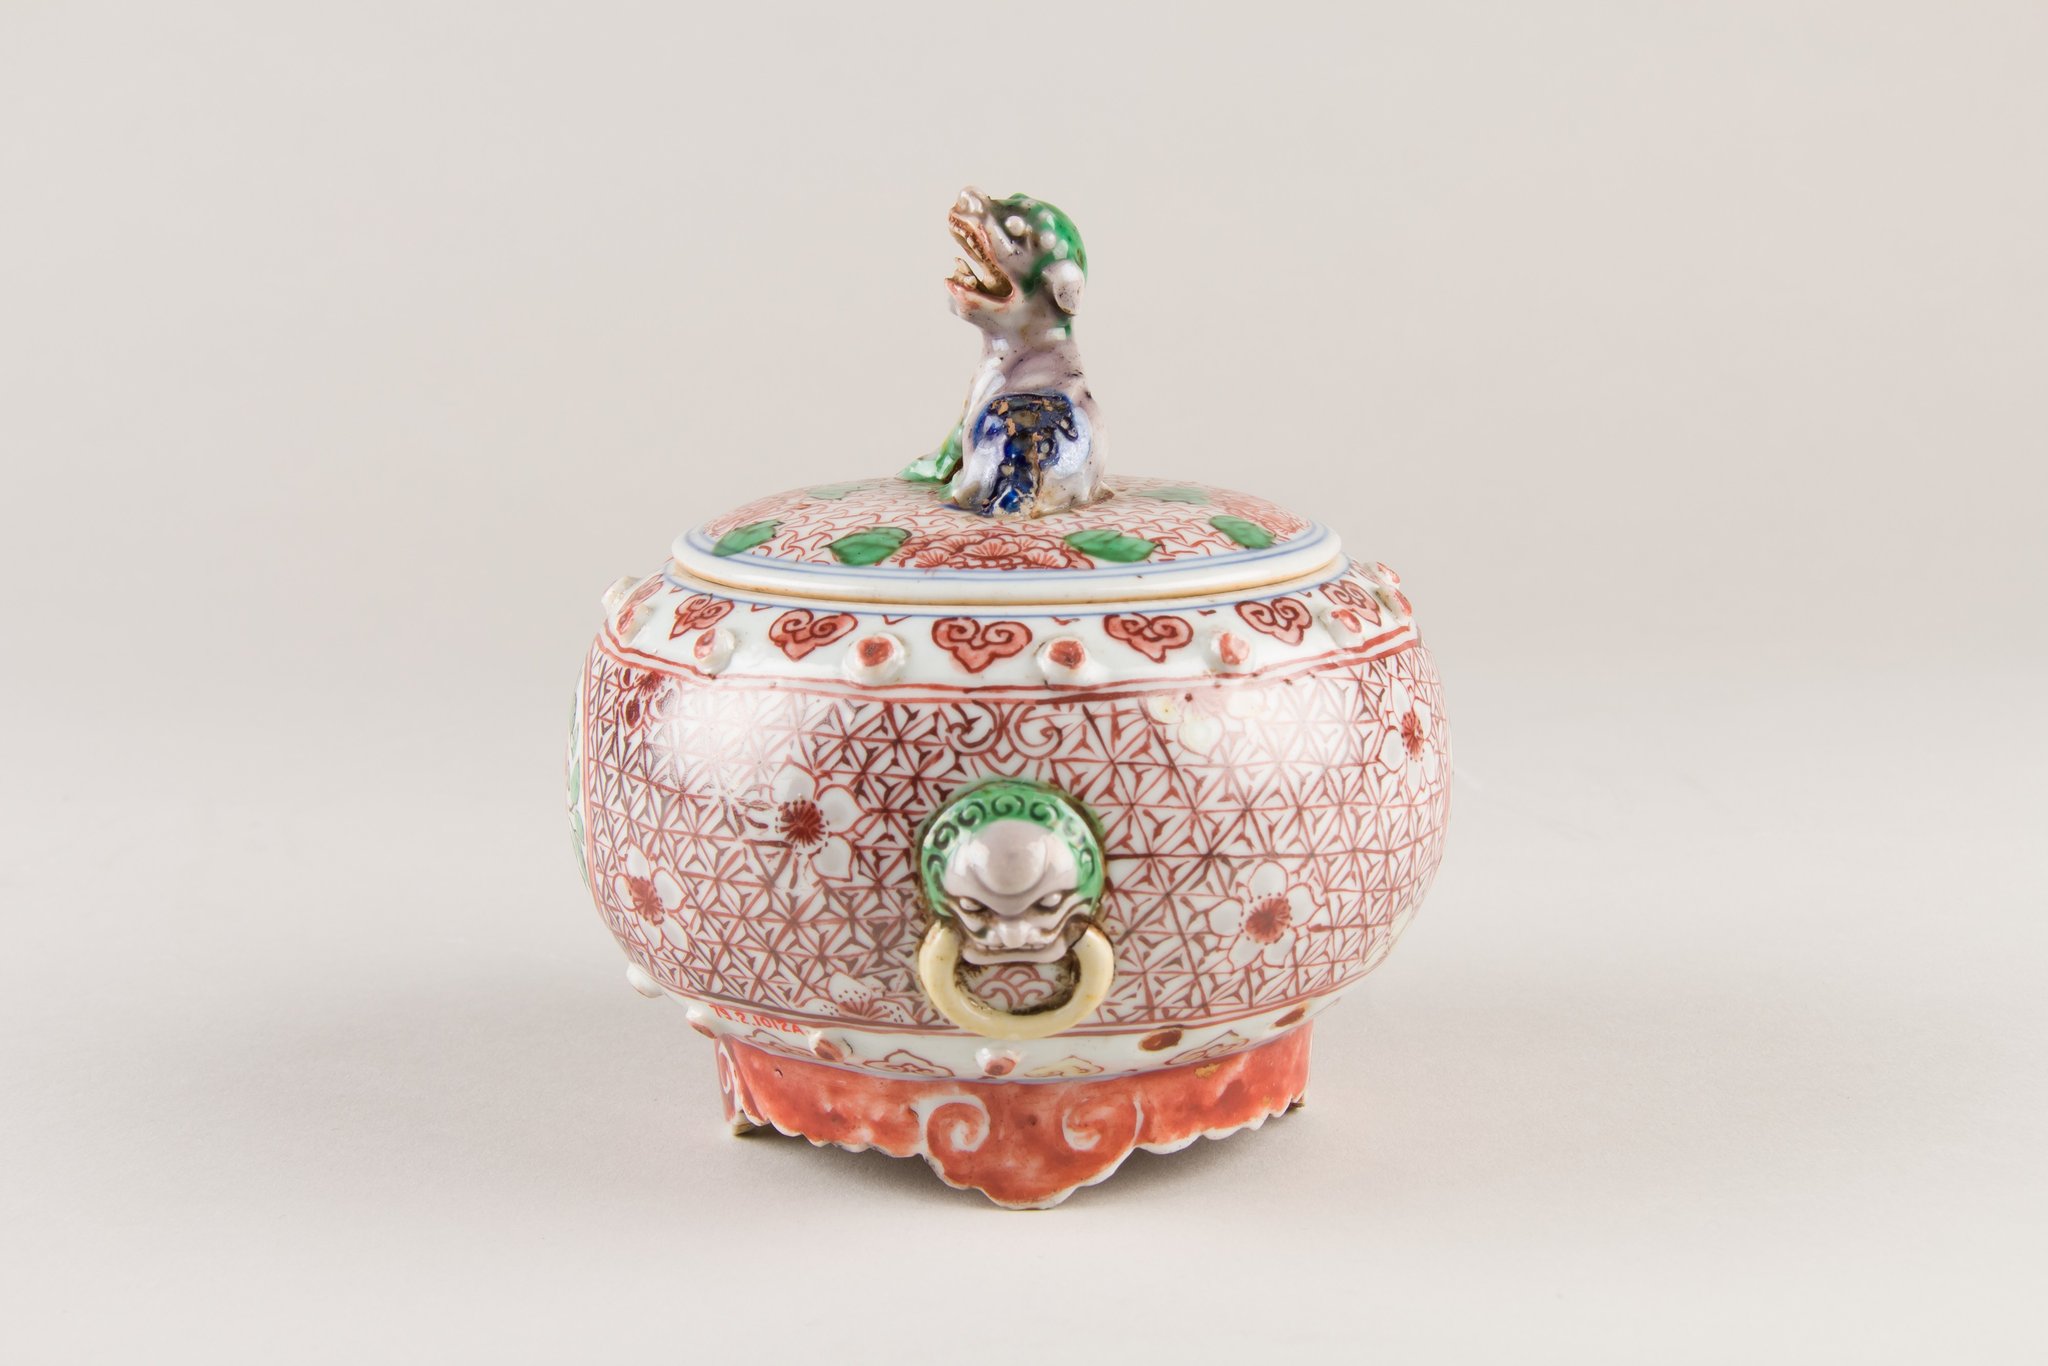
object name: covered box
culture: japanese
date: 1701-1800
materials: enamel, iron, porcelain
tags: lions